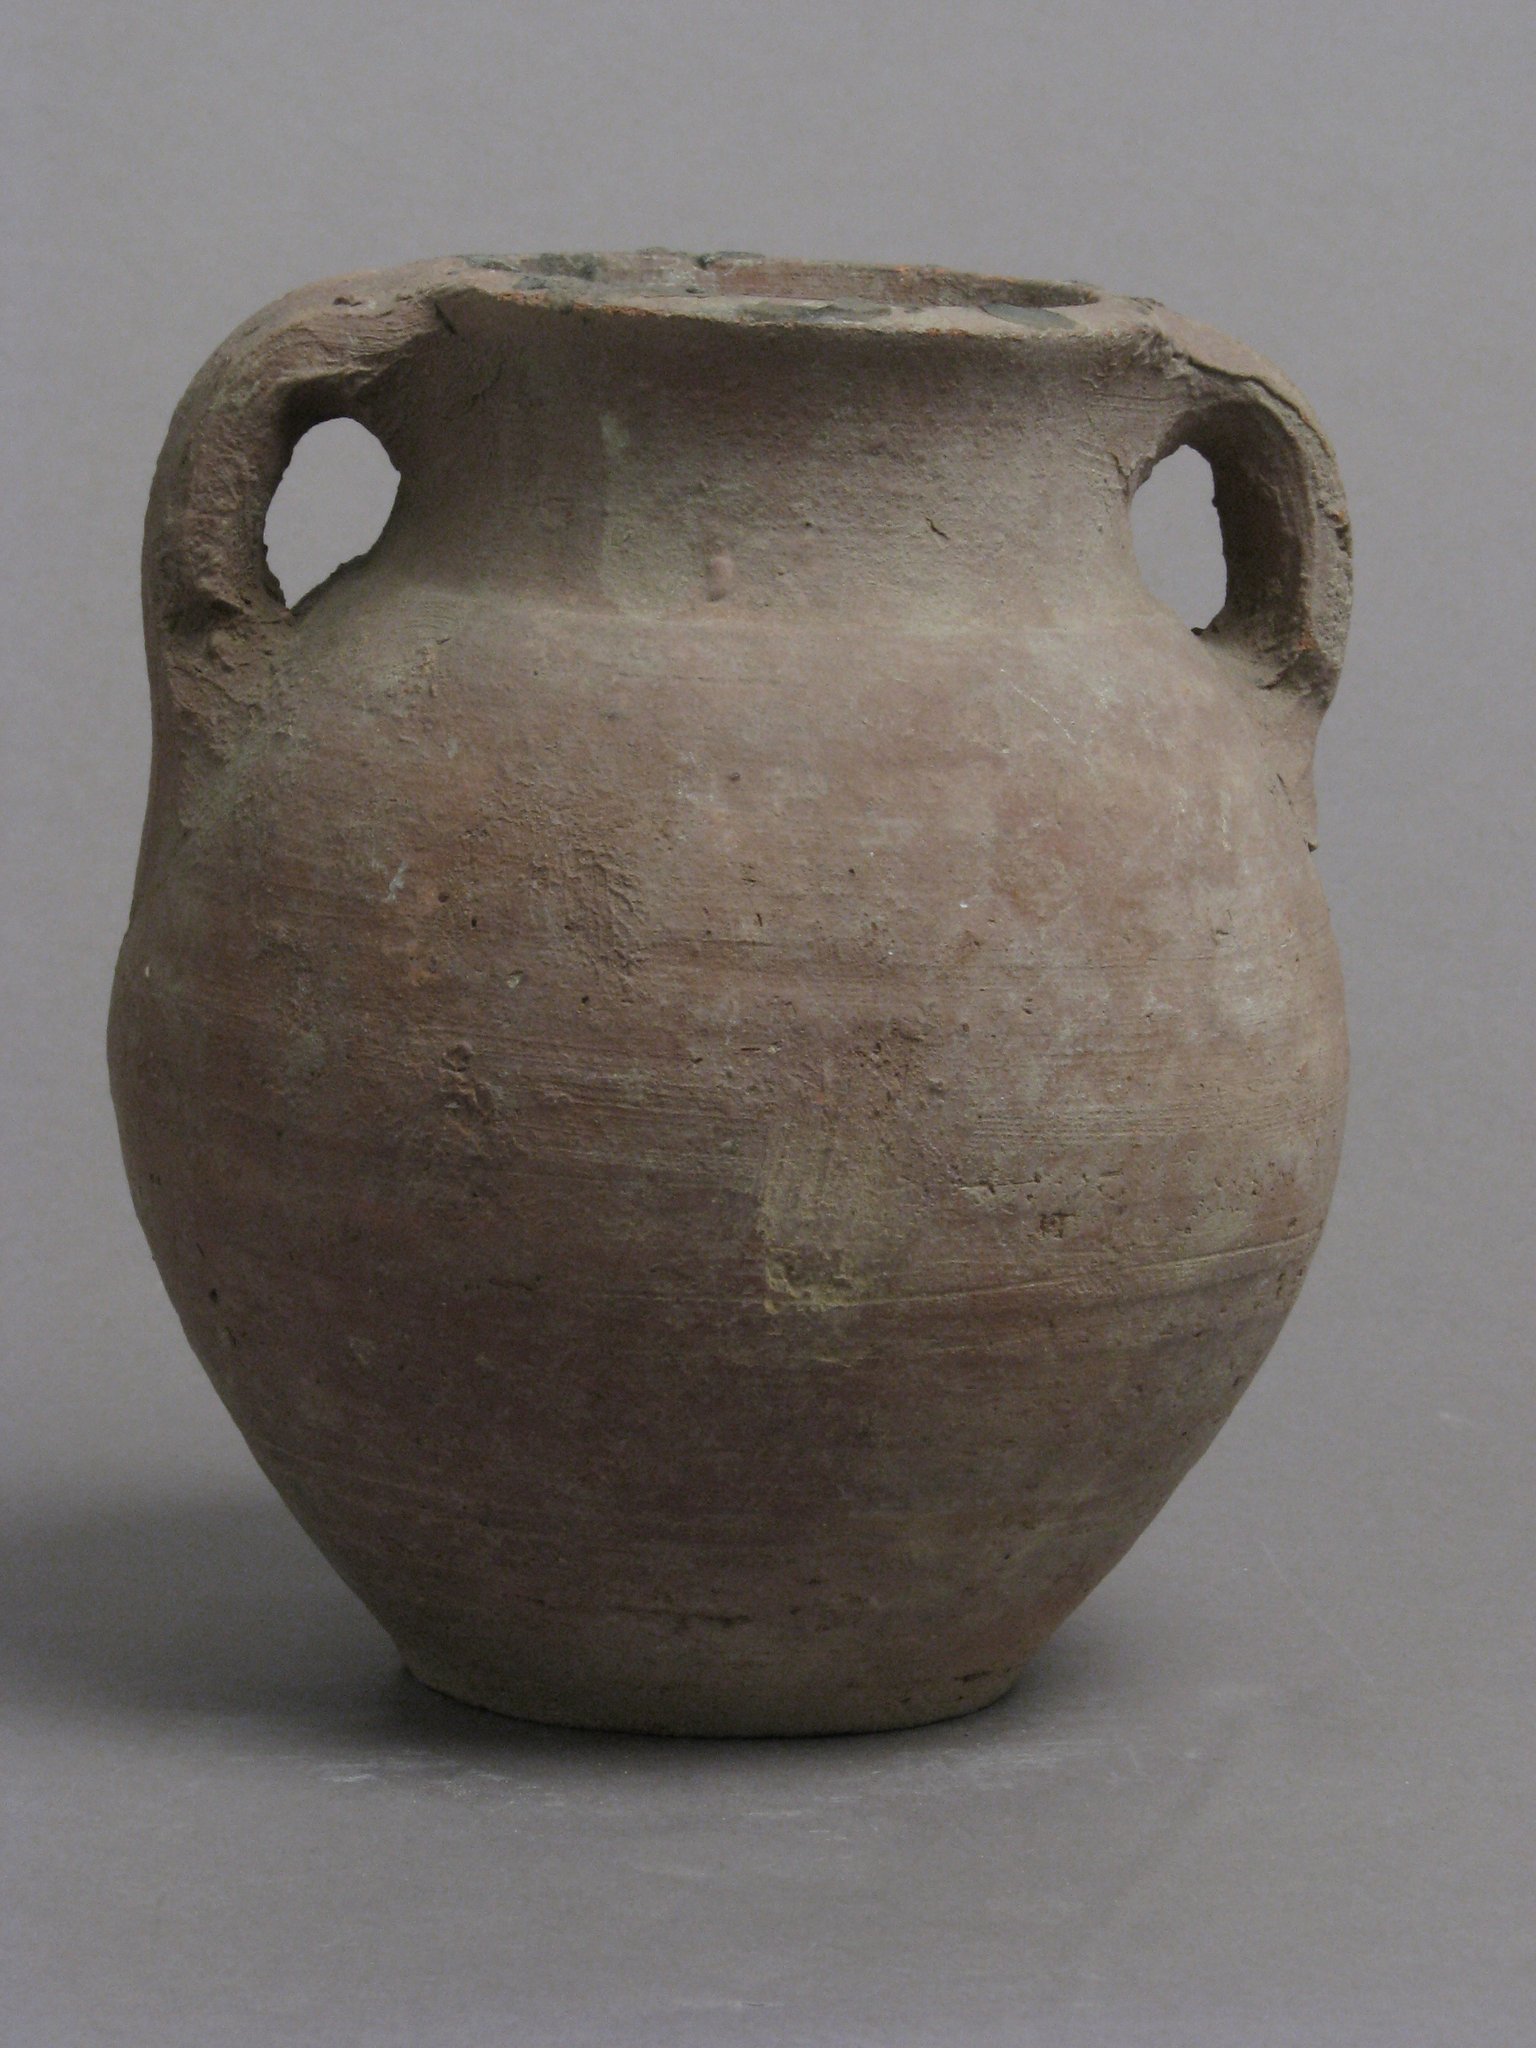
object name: vessel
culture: coptic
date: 301-700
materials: earthenware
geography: egypt